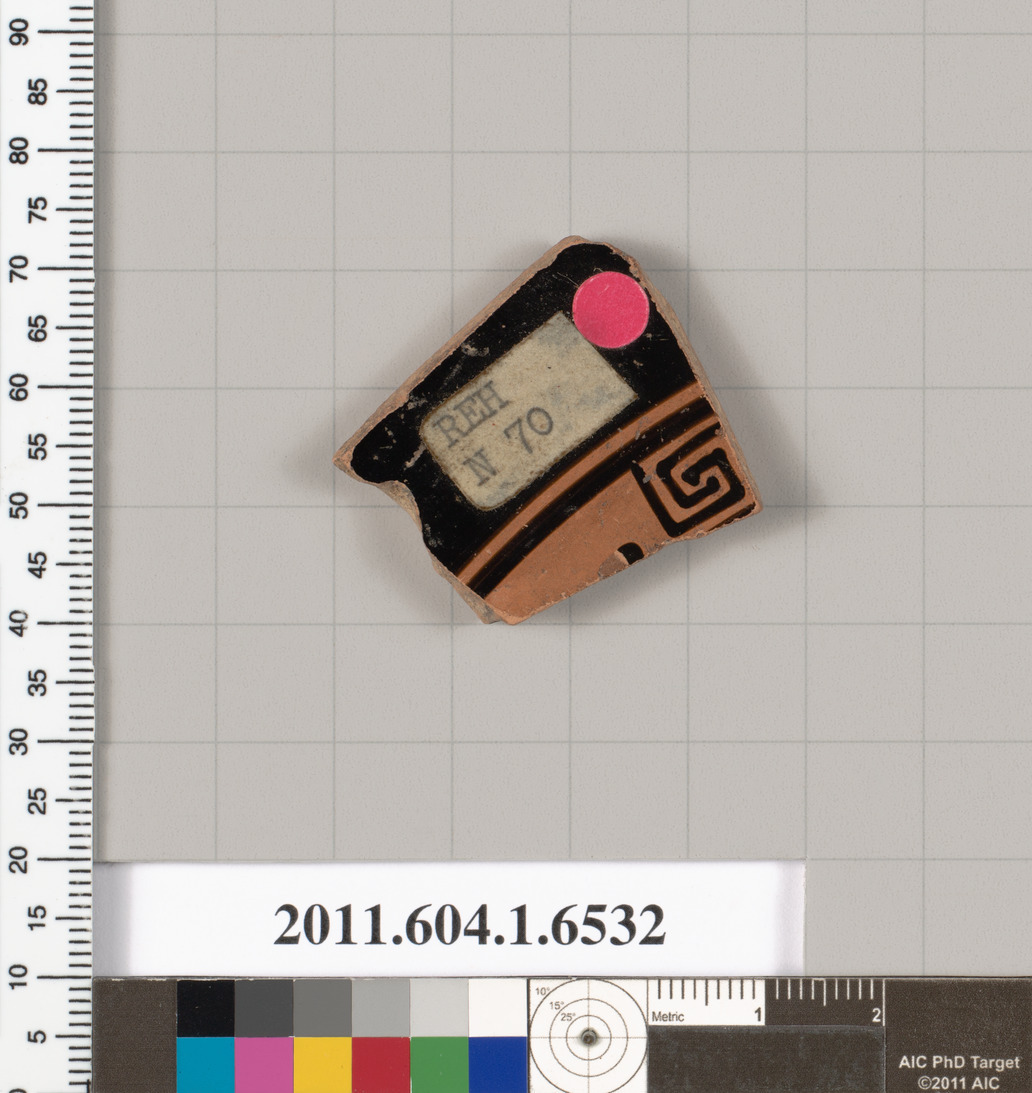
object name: kylix fragment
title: Terracotta fragment of a kylix (drinking cup)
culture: greek, attic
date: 490-480 BCE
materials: terracotta